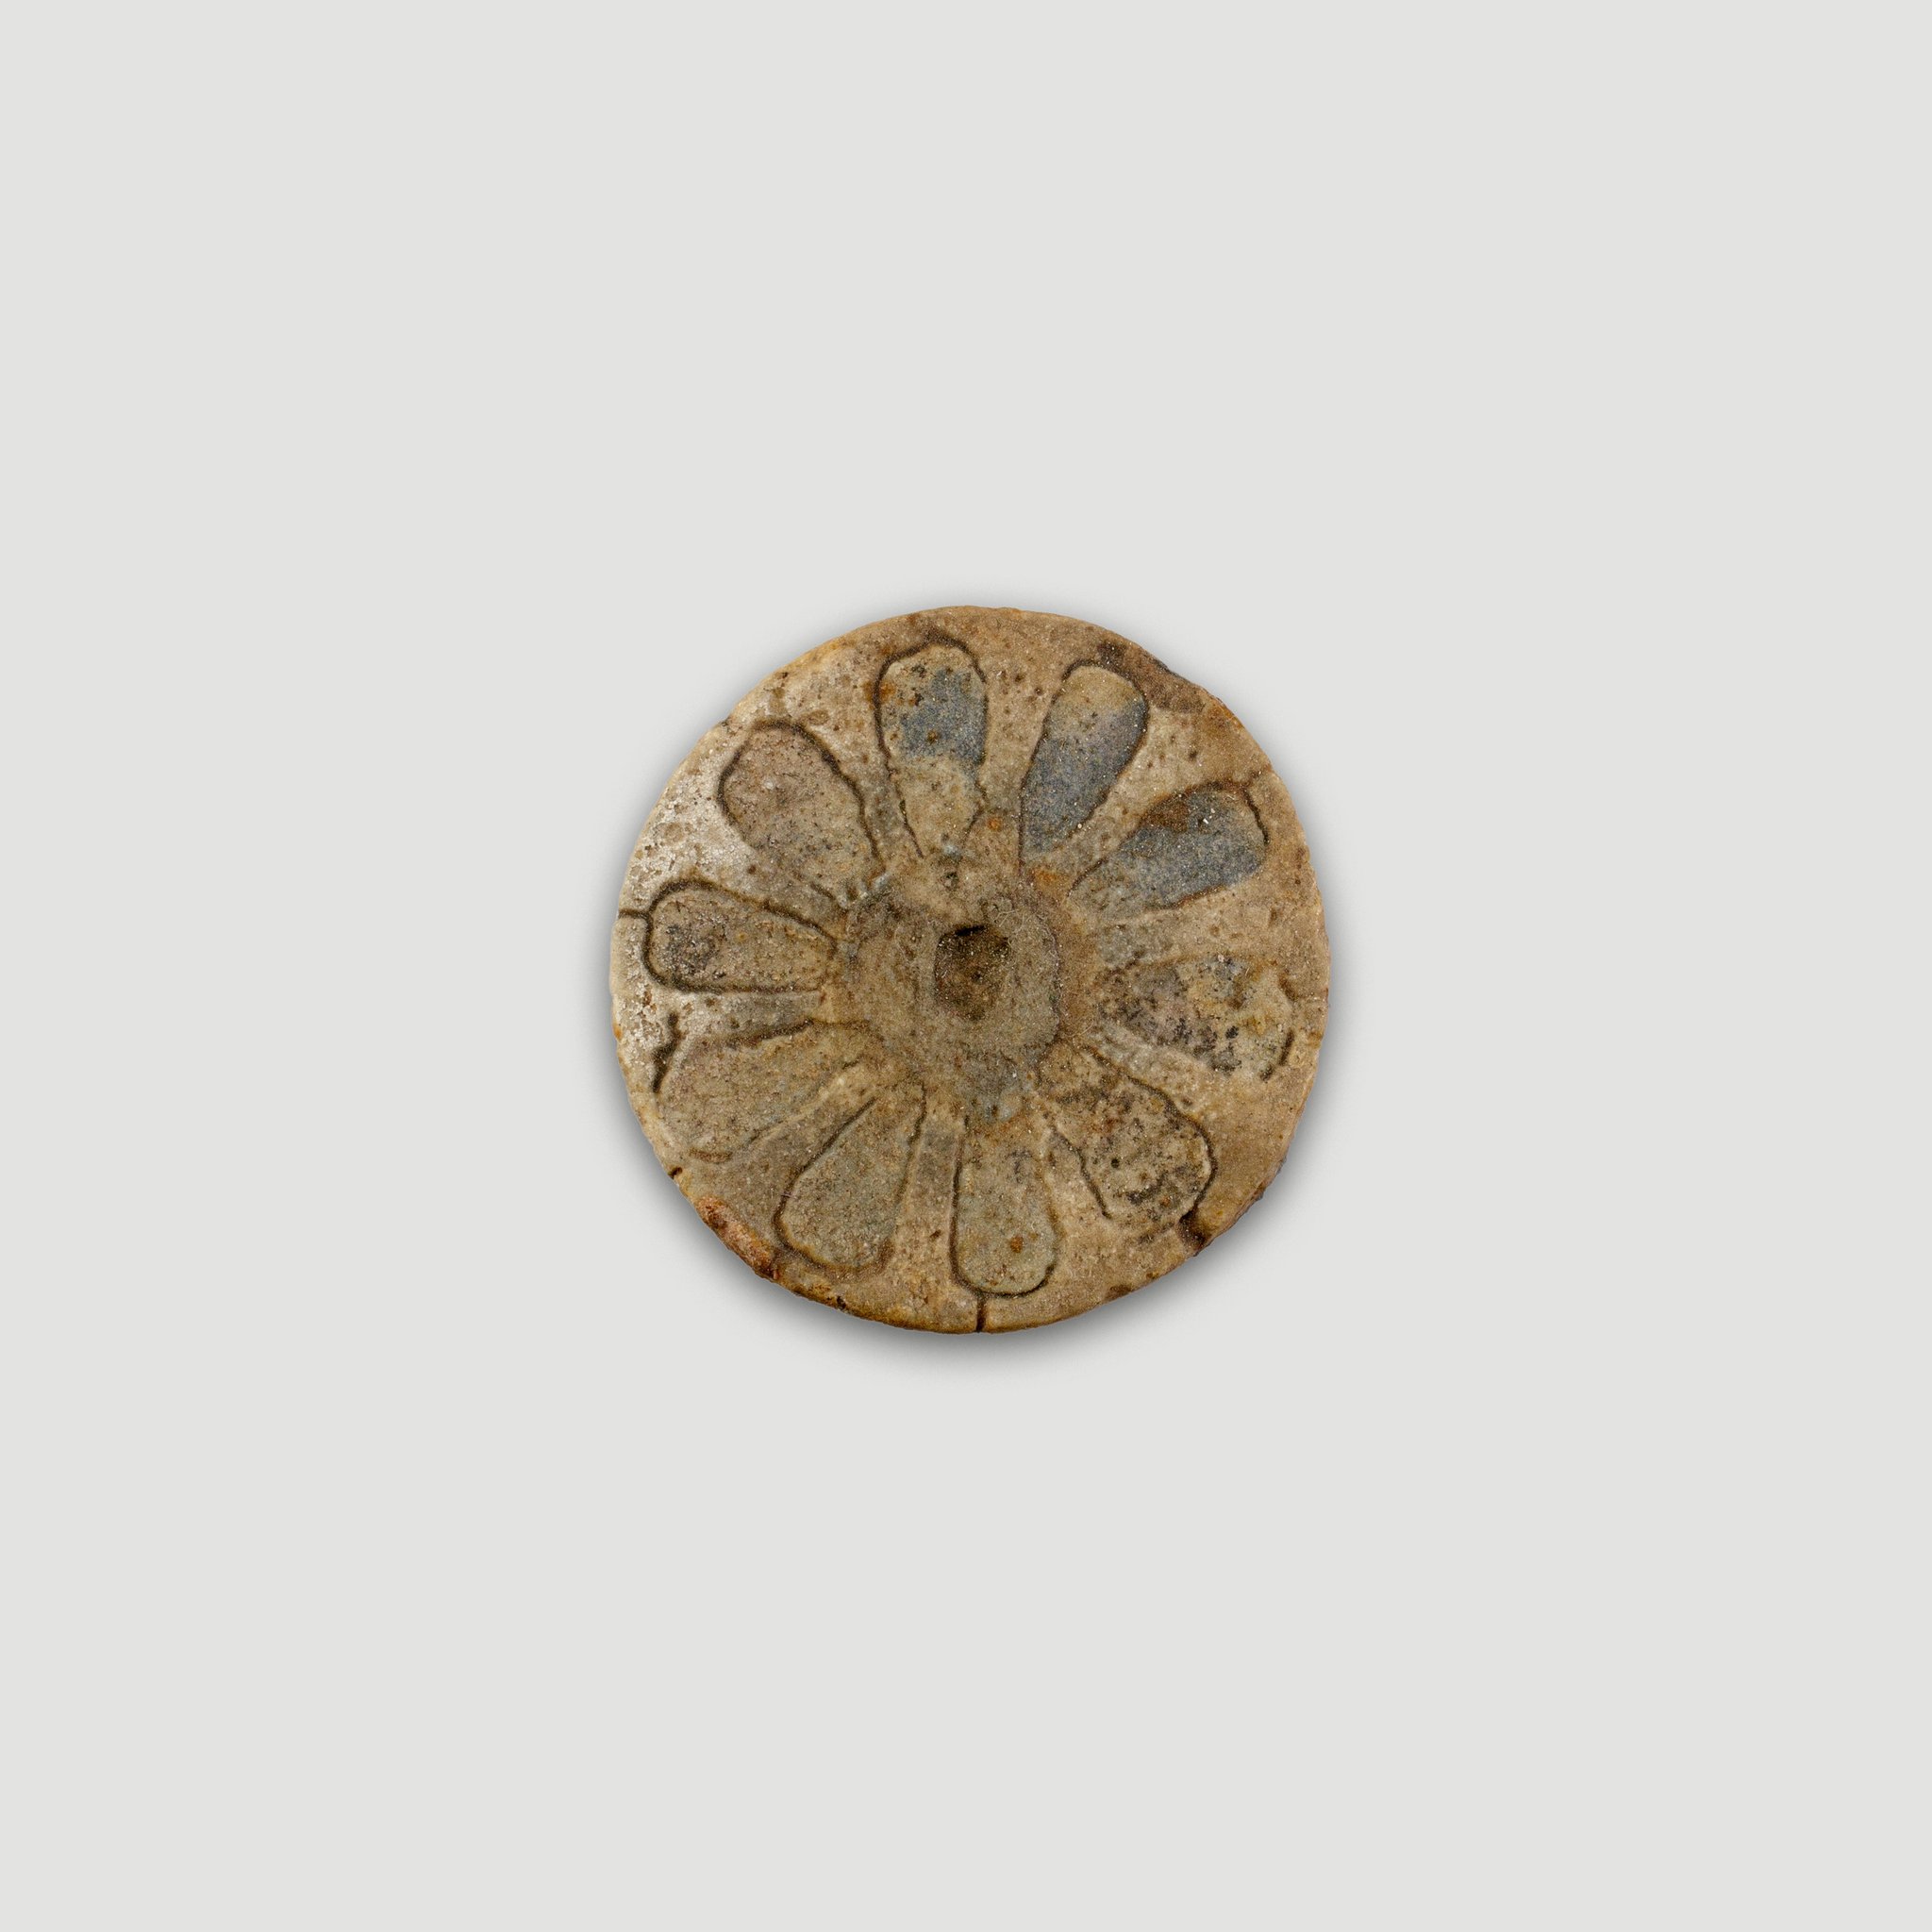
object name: tile, palace of ramesses ii, rosette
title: Tiles and ornaments from the palace of Ramesses II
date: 1279-1213 BCE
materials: faience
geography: egypt